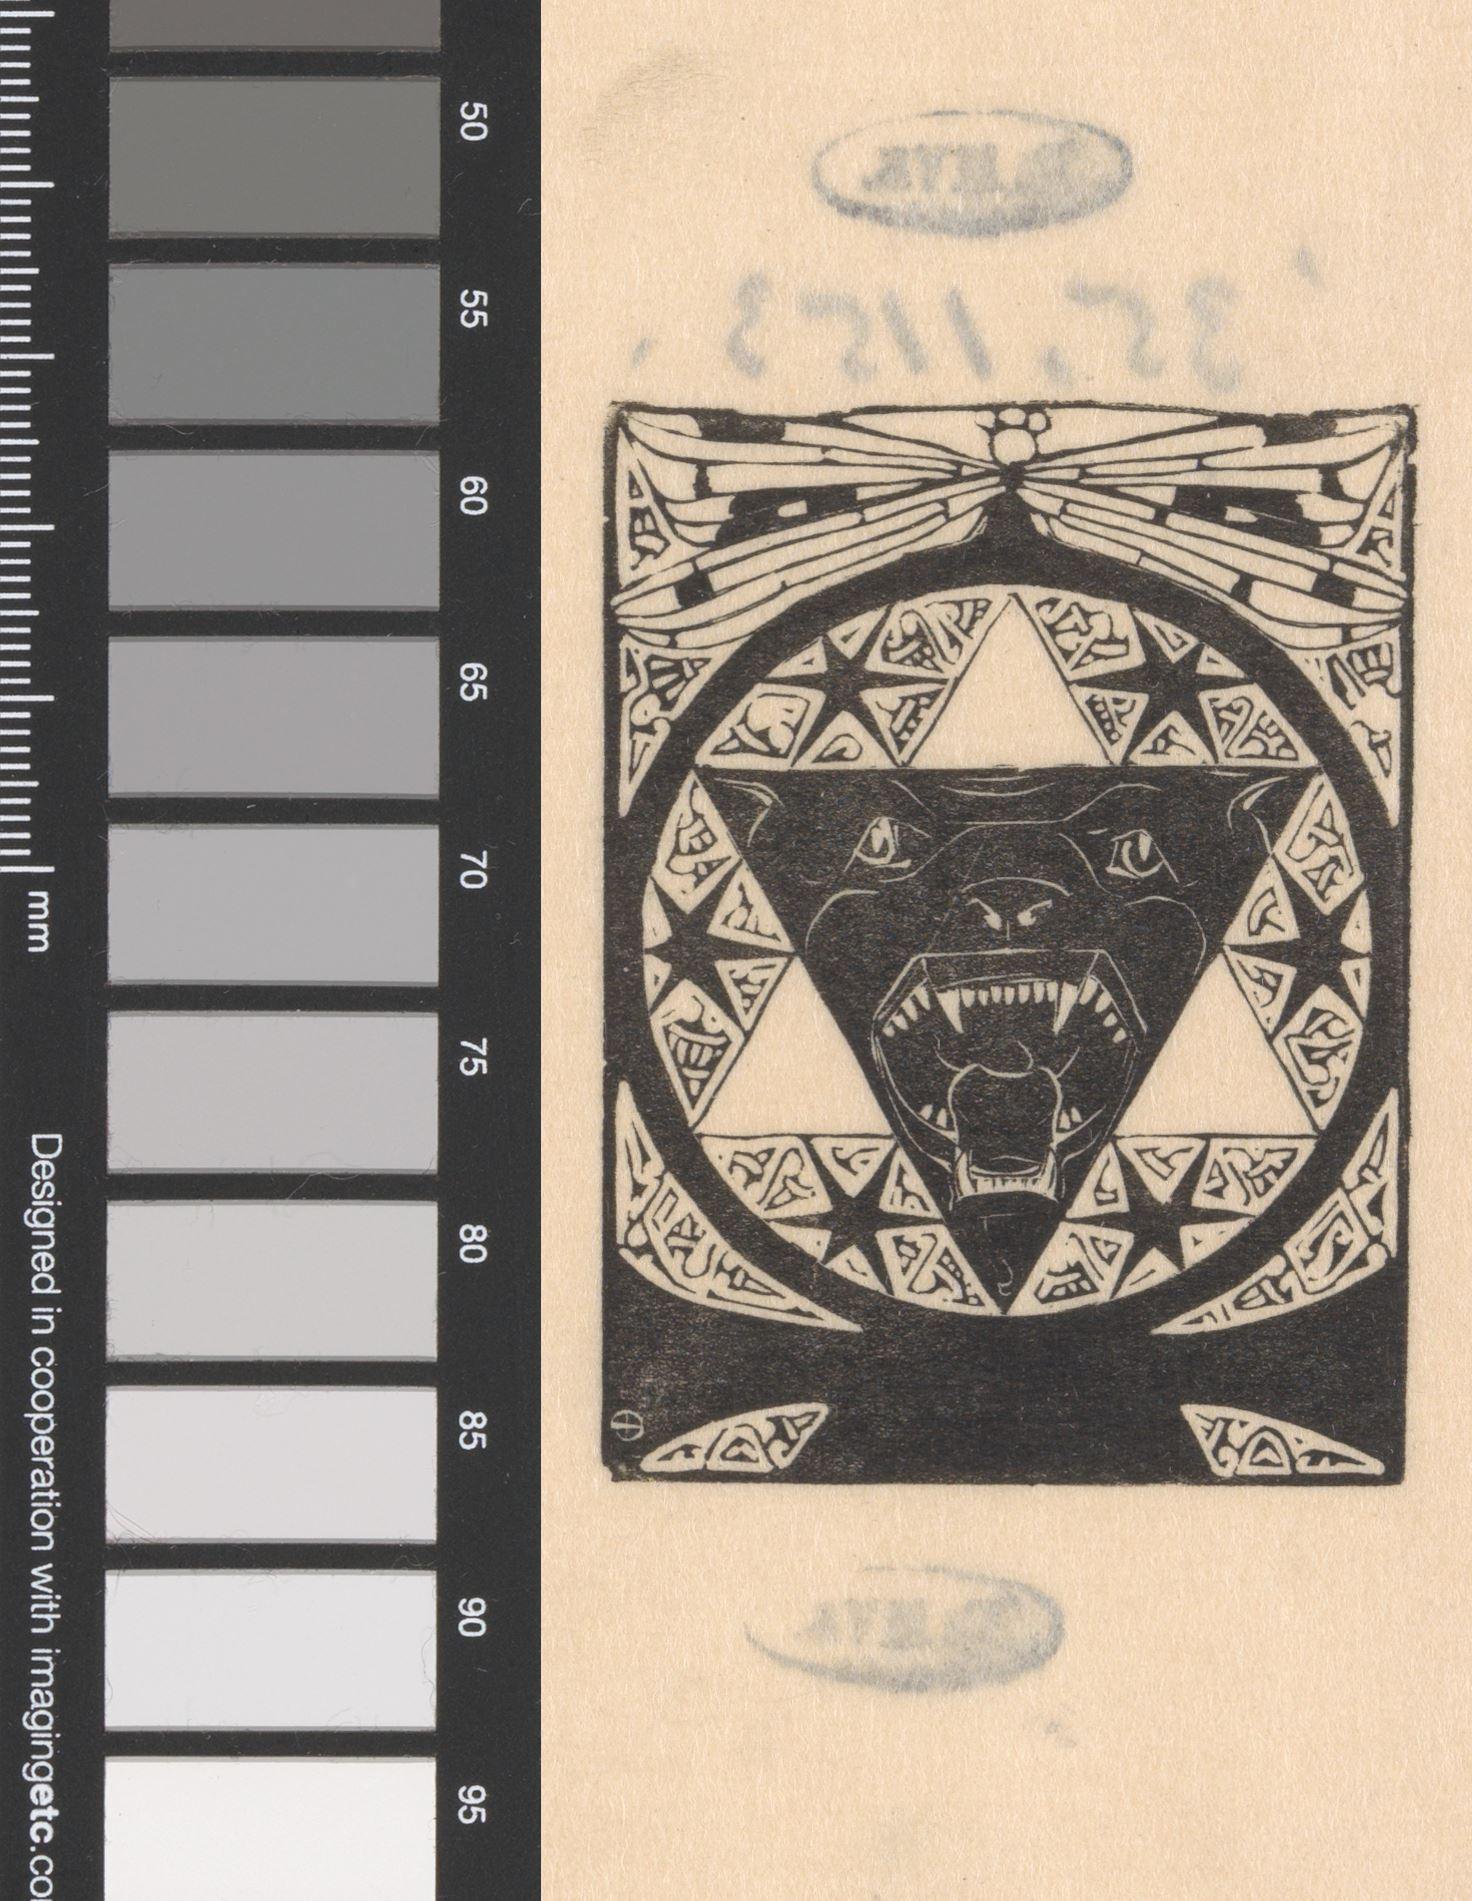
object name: print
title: Theosofisch embleem met brullende hondenkop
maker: mathieu lauweriks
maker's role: designer, draughtsman, print maker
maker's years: 1864-1932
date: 1895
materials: paper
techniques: woodcut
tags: stars, dog (+ head of an animal)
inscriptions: collector's mark: Lugt 2228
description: Een cirkel met bovenaan vleugels. In de cirkel zes sterren, een witte naar boven gerichte driehoek en een zwarte naar onder gerichte driehoek. In de zwarte driehoek een brullende hondenkop.